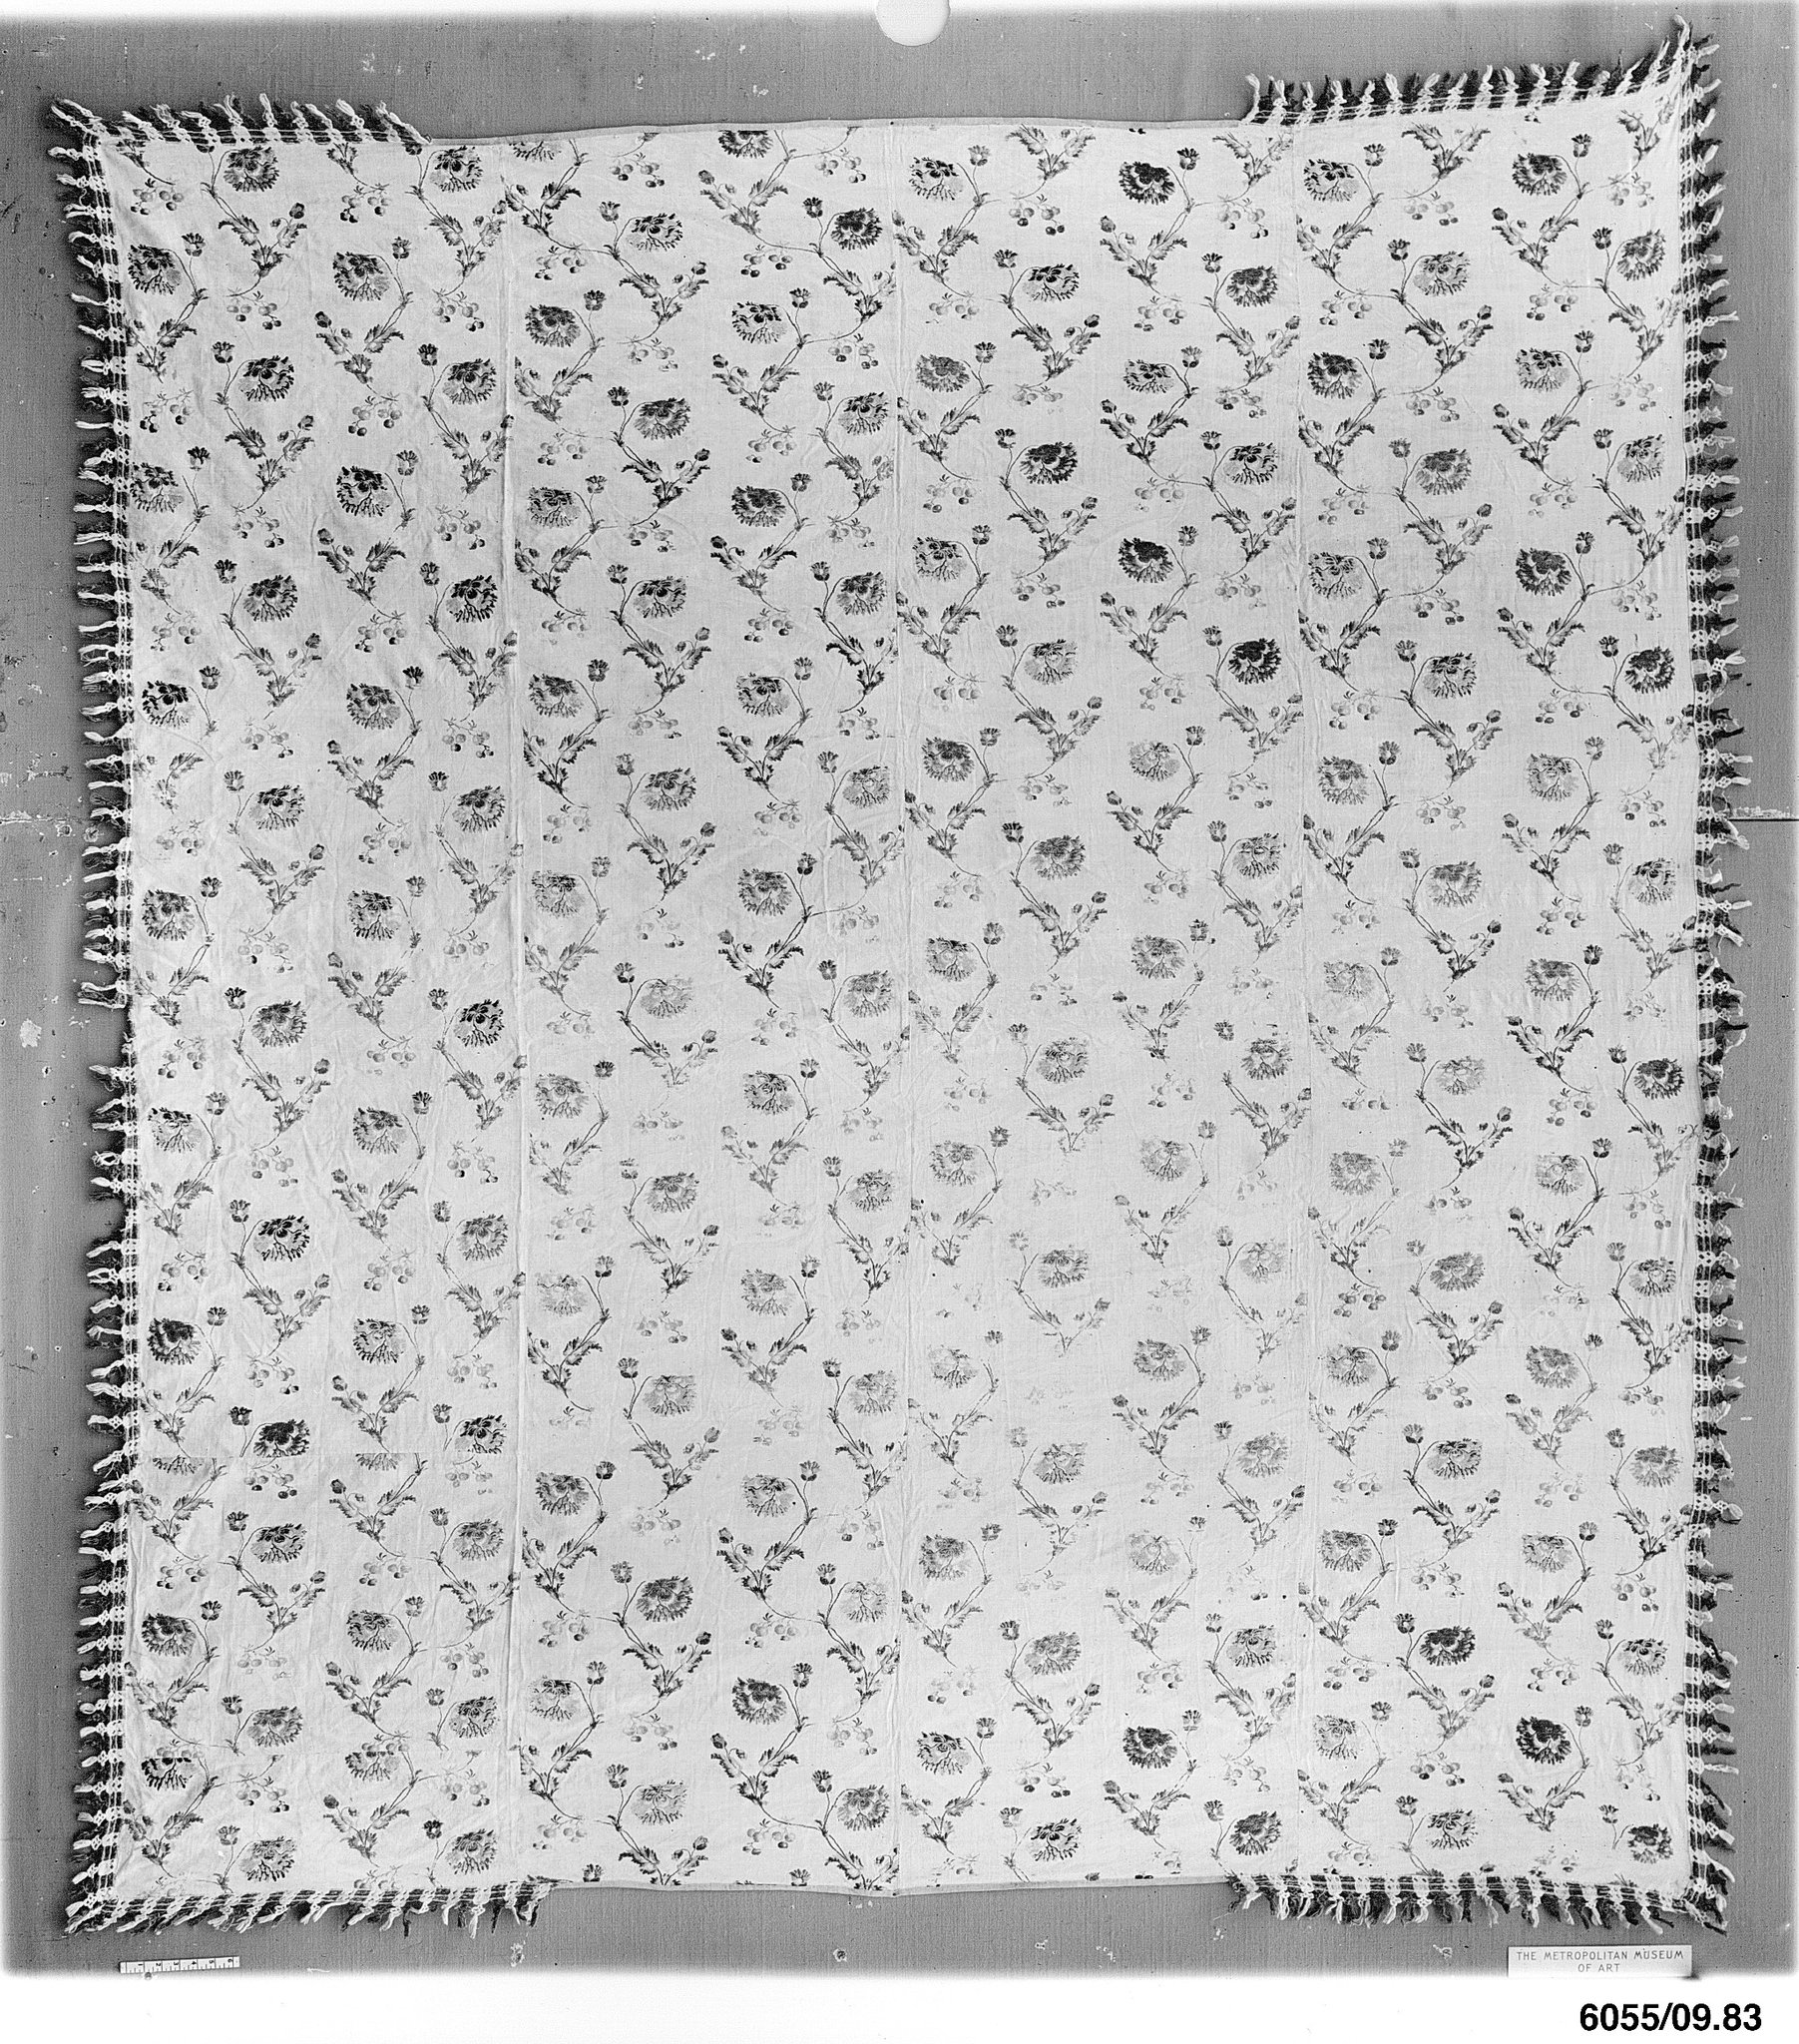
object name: bedspread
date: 1801-1833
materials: cotton, wool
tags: flowers